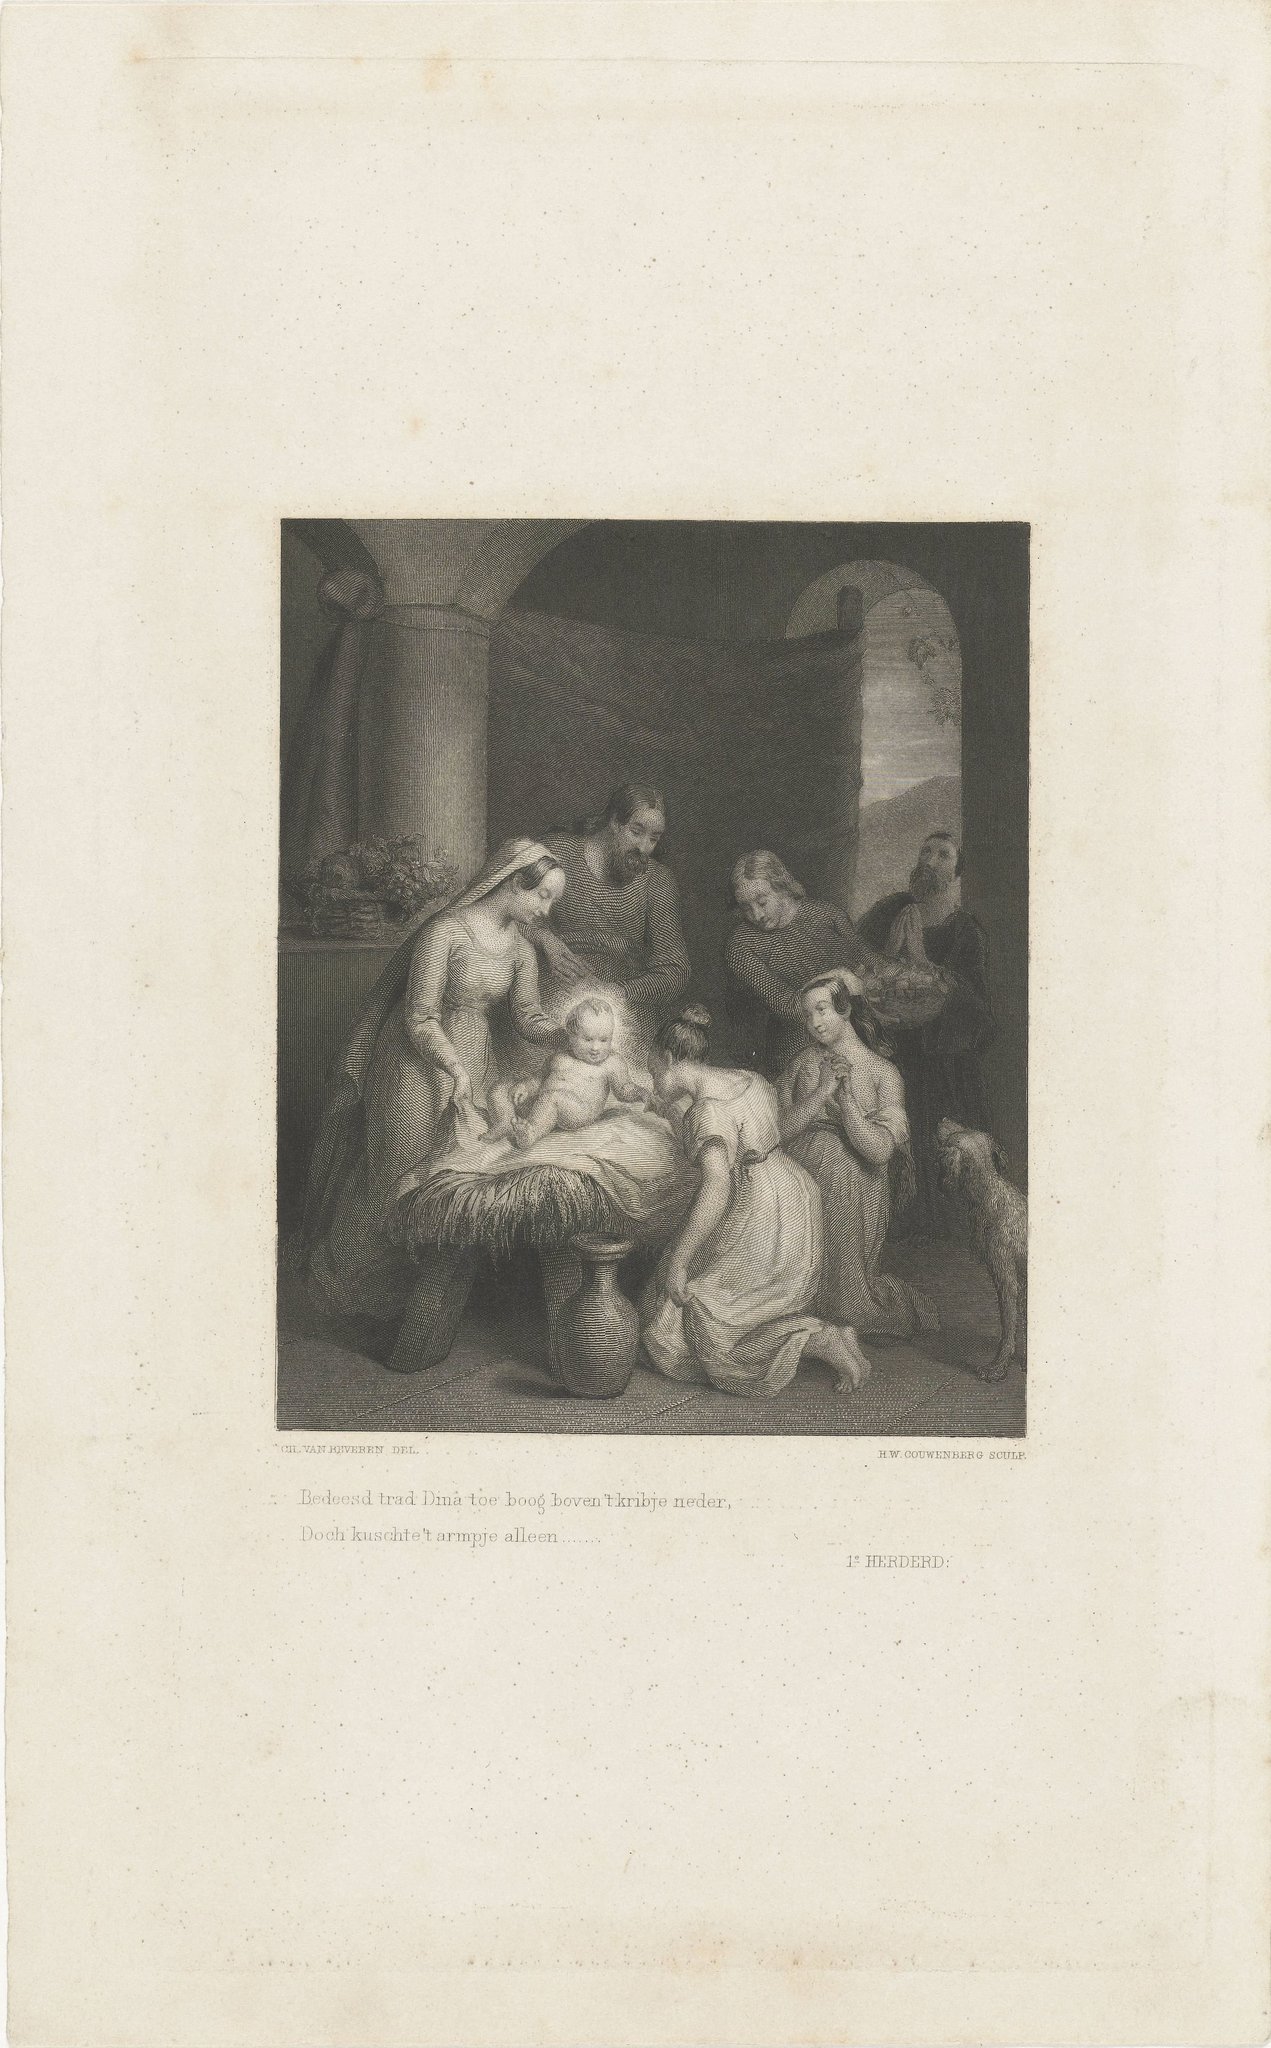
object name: book illustration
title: Aanbidding van het Kind door twee herdersmeisjes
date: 1830-1845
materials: paper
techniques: engraving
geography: amsterdam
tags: adoration of the christ-child by the shepherds; mary and joseph present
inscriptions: collector's mark: Lugt 2228